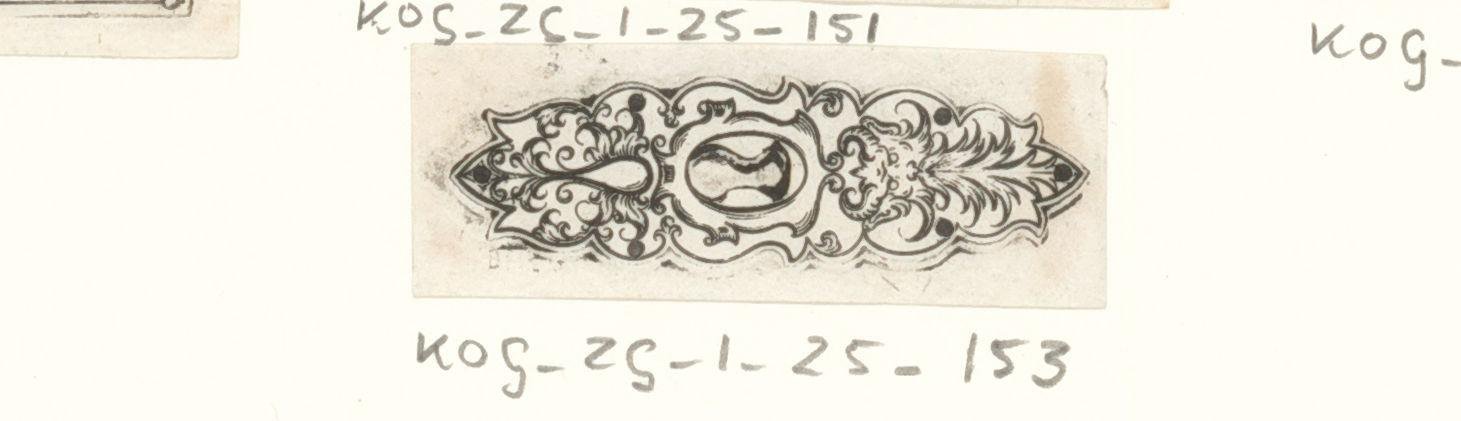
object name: print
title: Sater met ornamentale versiering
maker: Anonymous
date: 1600-1699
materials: paper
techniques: engraving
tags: satyrs, fauns, sileni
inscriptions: collector's mark: Lugt 963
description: Onderwerpsrubrieken binnen de Atlas Zeden en Gewoonten: Zeden en Gewoonten in Engeren Zin, De Woning, Huisraad, Zilverwerk.